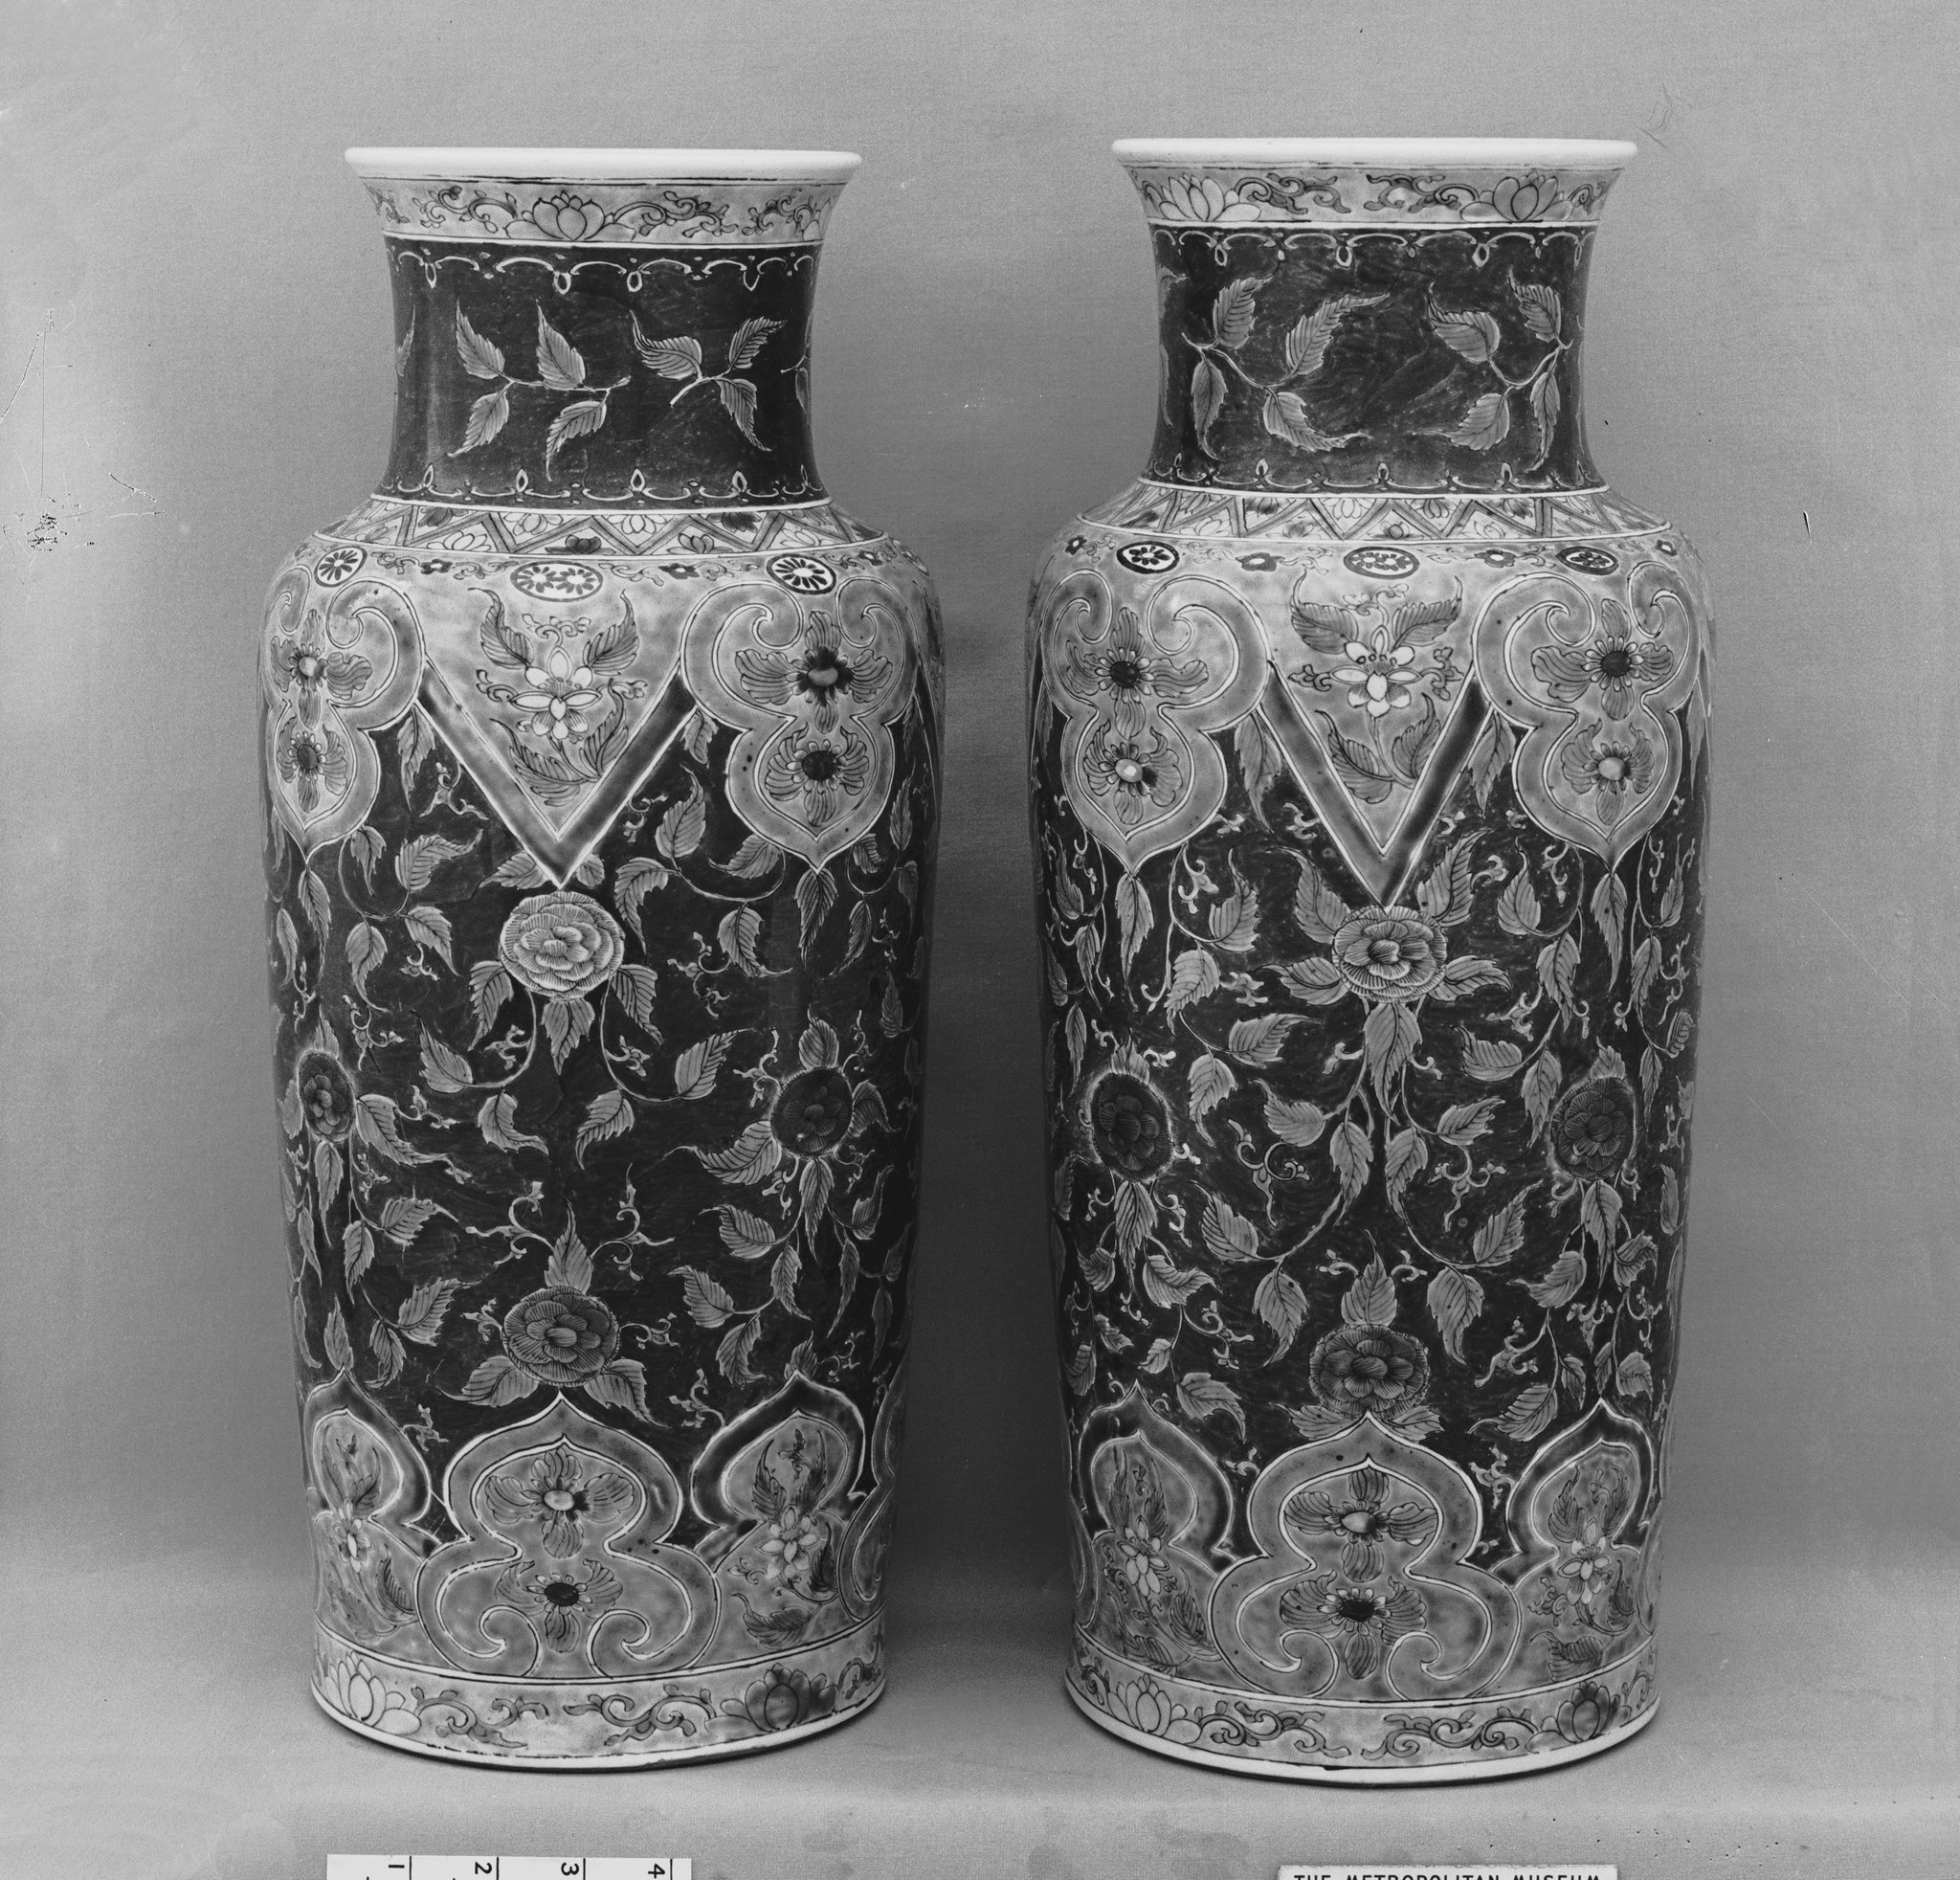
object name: vase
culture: chinese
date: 1767-1833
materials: enamel, porcelain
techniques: painting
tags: flowers,leaves